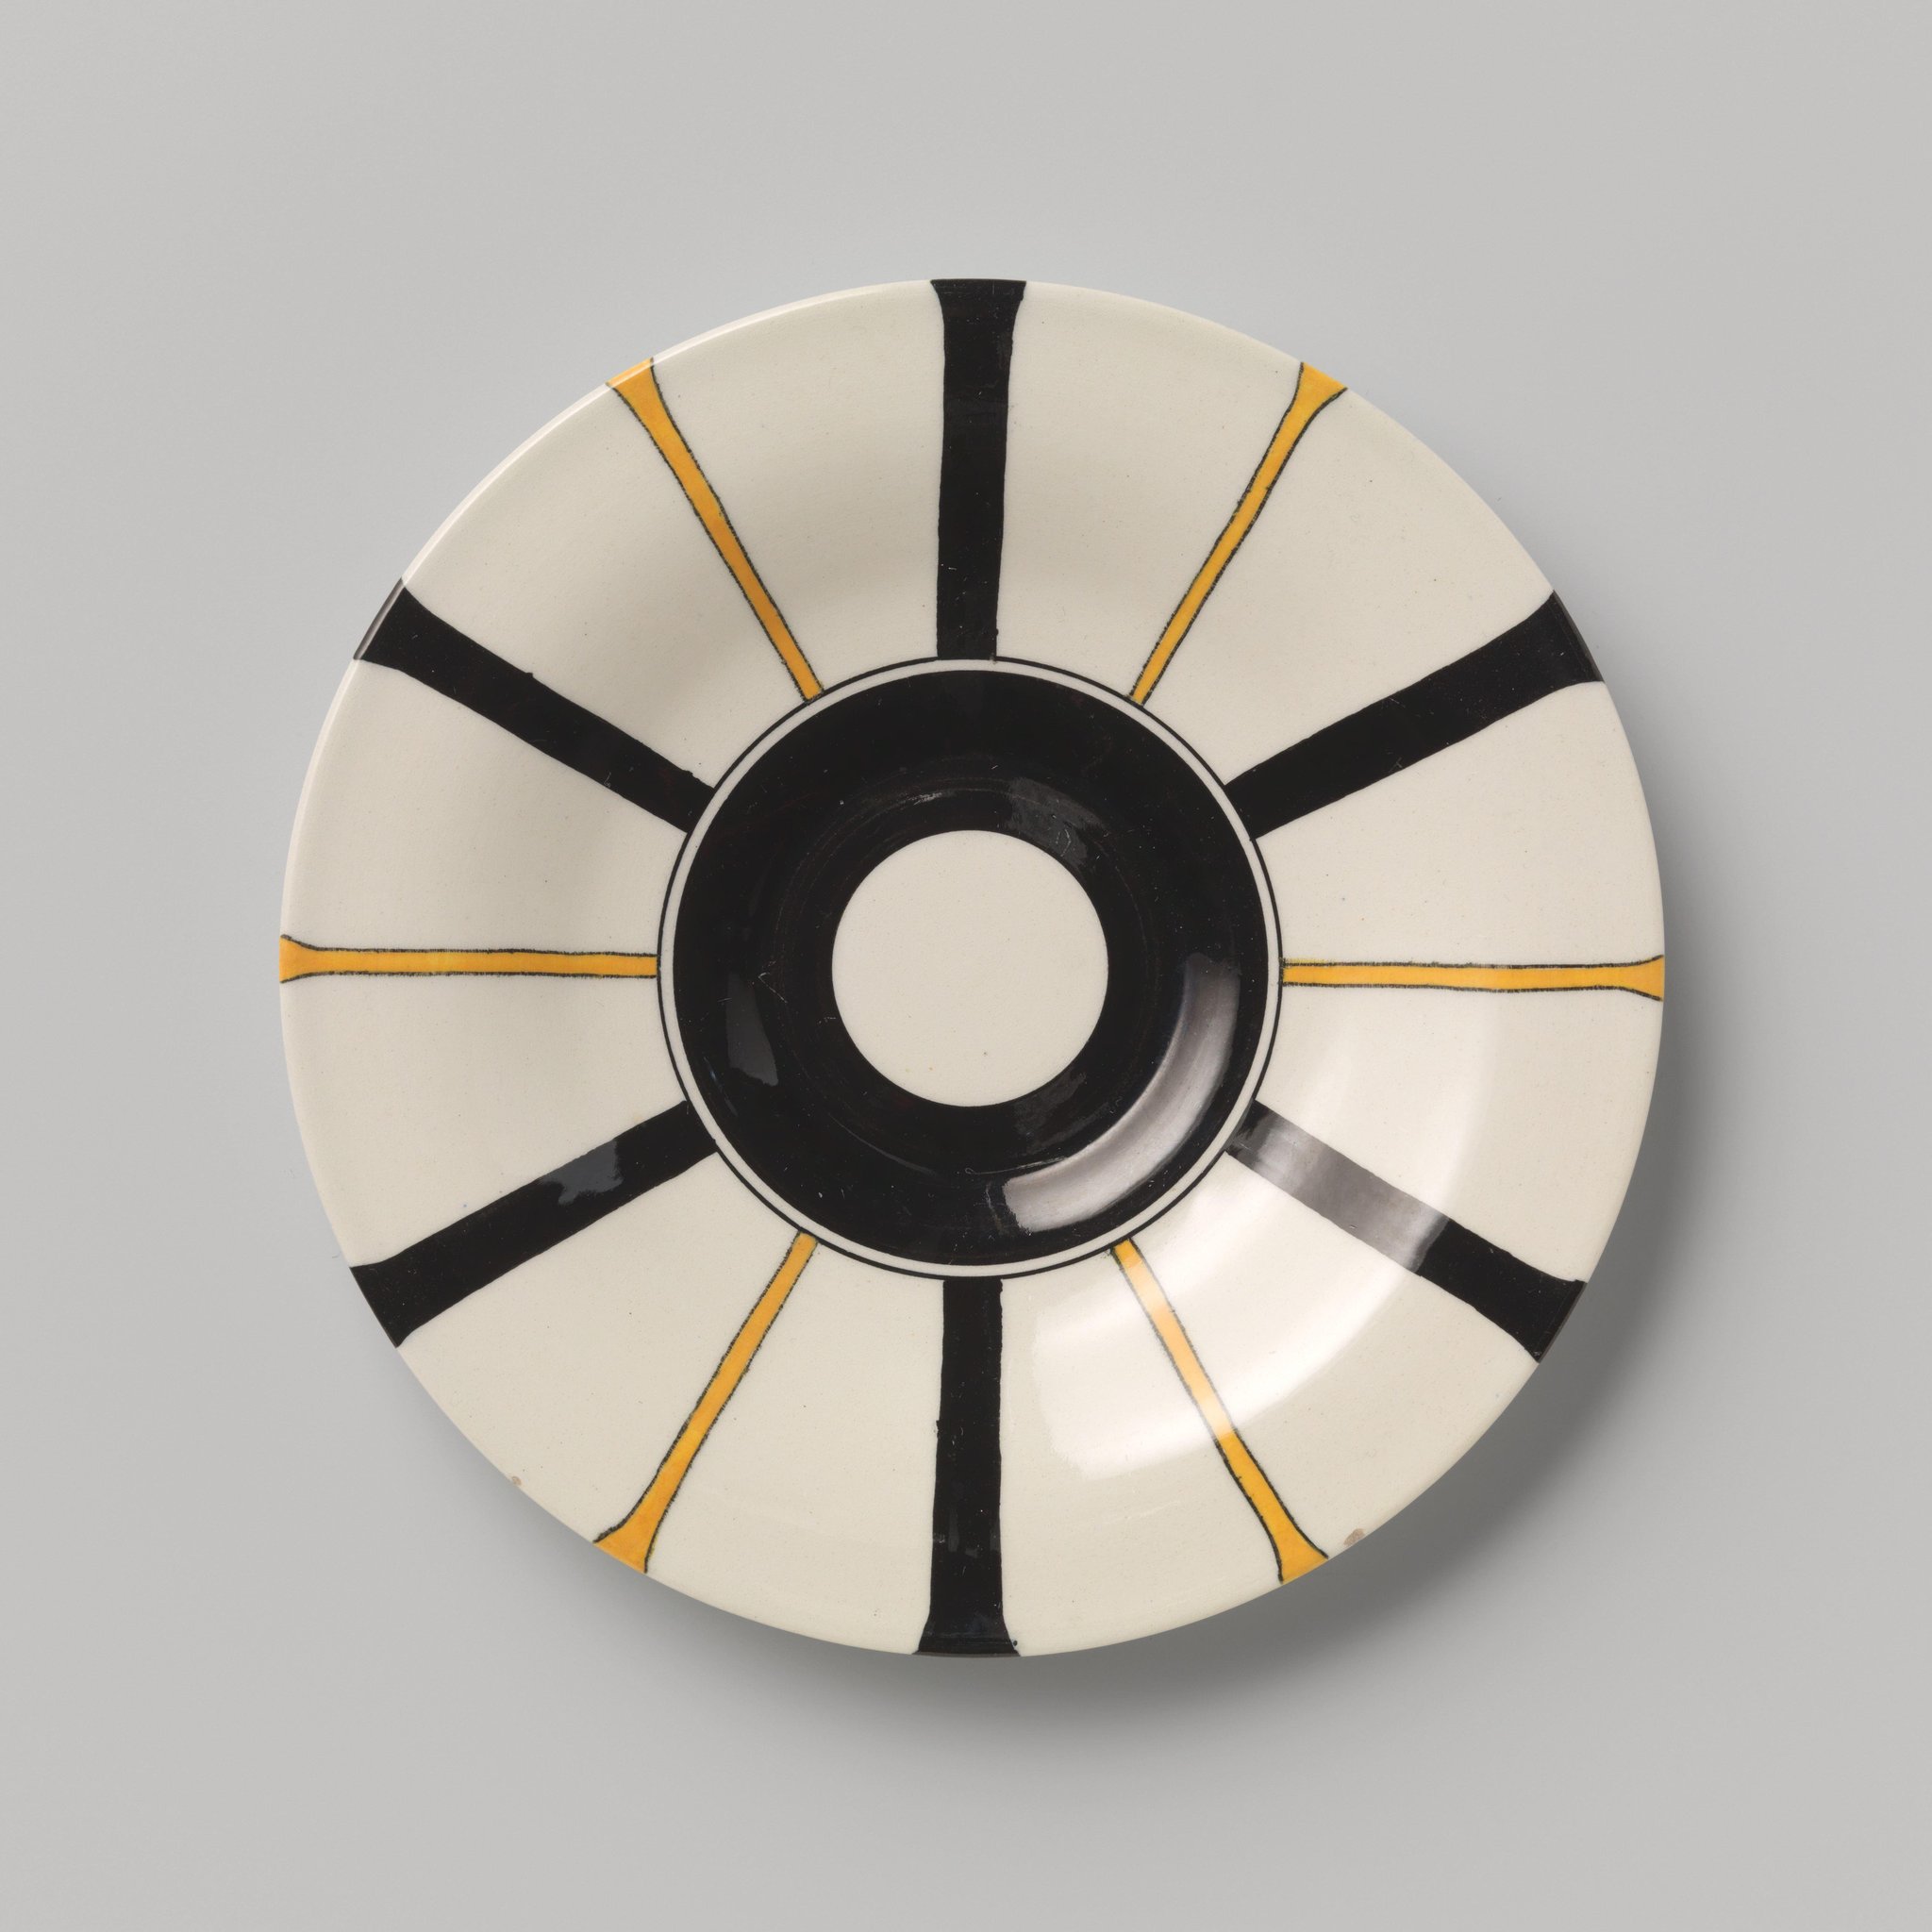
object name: platter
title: Schotel met radiaalsgewijs lijnendecor in geel en zwart op crème fond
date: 1925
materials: earthenware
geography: arnhem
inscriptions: mark: ‘cirkelvormig stempel in zwart: Colenbrander "Ram" Arnhem-Holland rondom een ramskop, 110.’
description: Schotel van aardewerk met een radiaalsgewijs lijnendecor in geel en zwart op crème fond. Gemerkt met cirkelvormig stempel in zwart: Colenbrander "Ram" Arnhem-Holland rondom een ramskop, 110.